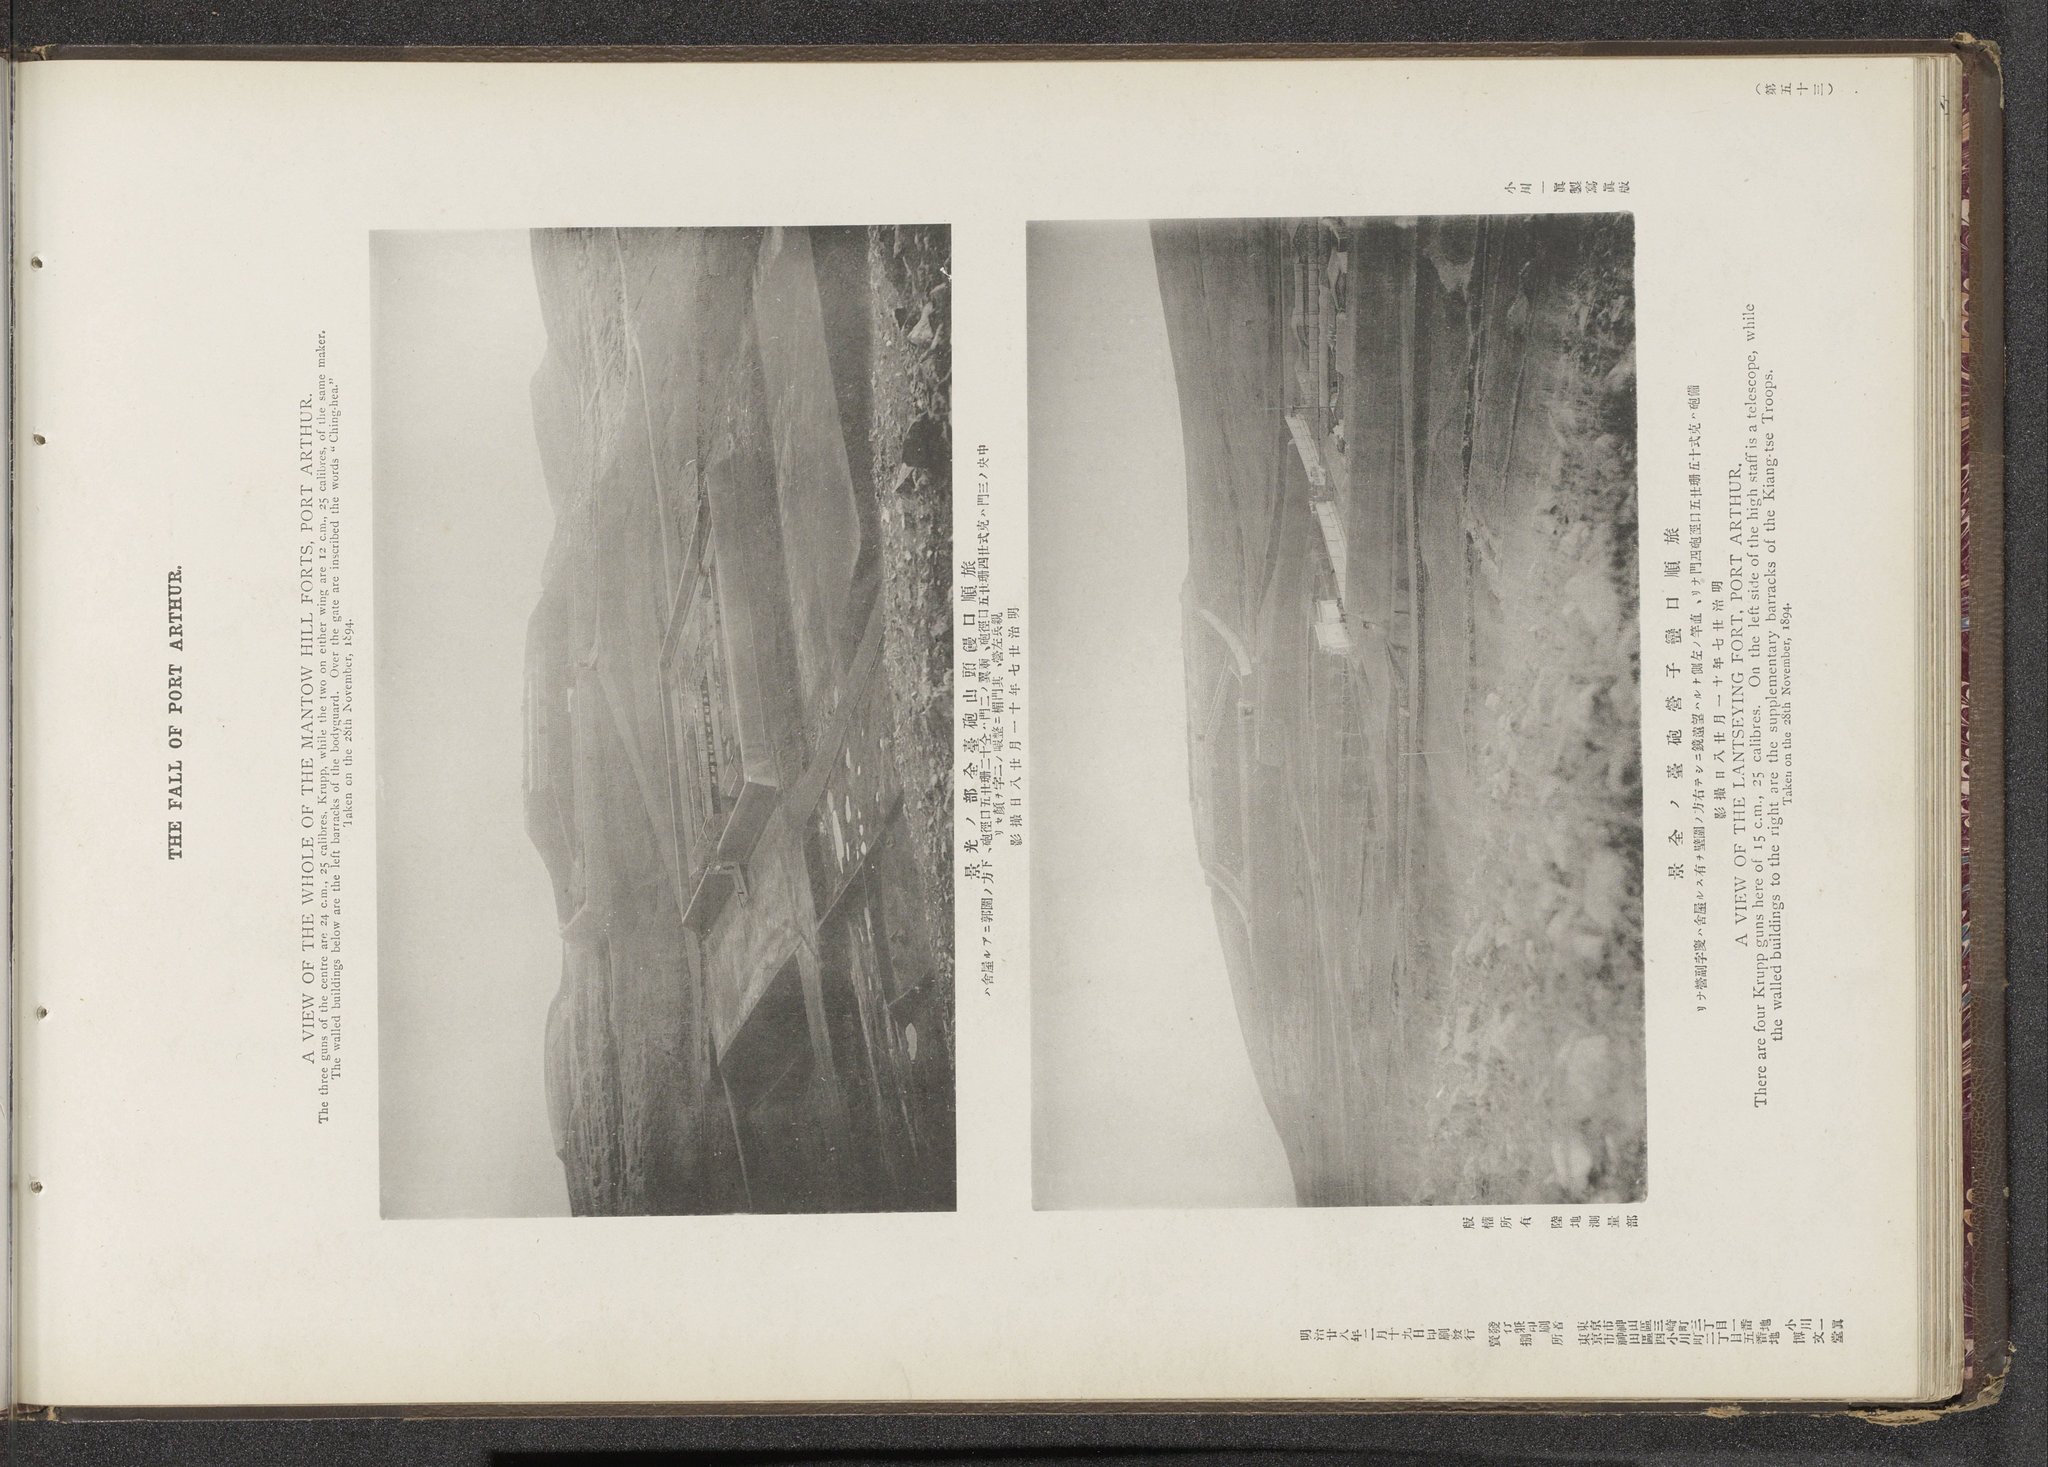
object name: page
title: A view of the Lantseying fort, Port Arthur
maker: kazumasa ogawa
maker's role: auteur, fotograaf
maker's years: 1860-1929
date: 1894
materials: paper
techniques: photograph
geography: manchuria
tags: fortress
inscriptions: inscription: ‘The three guns of the centre are (...) to the right are the supplementary barracks of the Kiang-tse Troops.’, inscription: ‘The fall of Port Arthur.’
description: Boven een gezicht op de forten van de Mantow-heuvel, onder een gezicht op het Lantseying-fort.